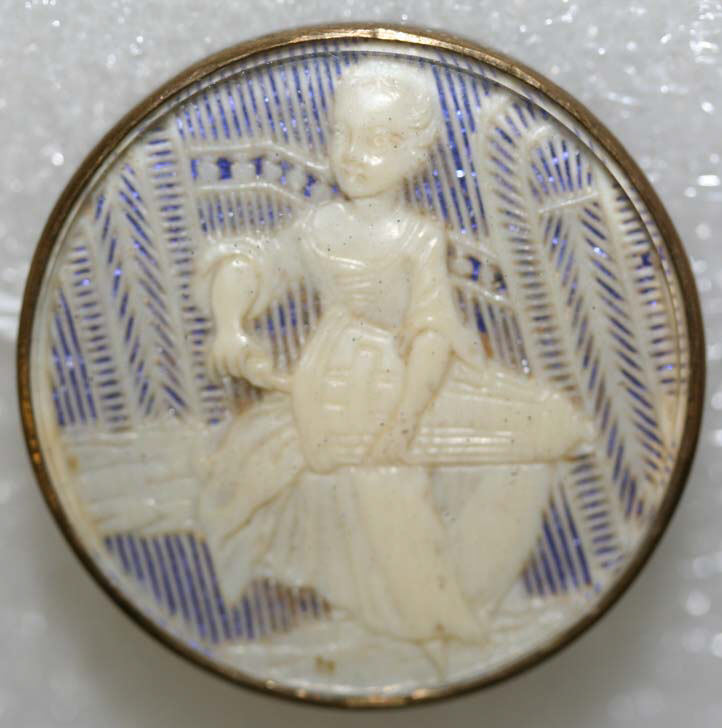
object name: button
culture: french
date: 1775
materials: glass, ivory, metal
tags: girls